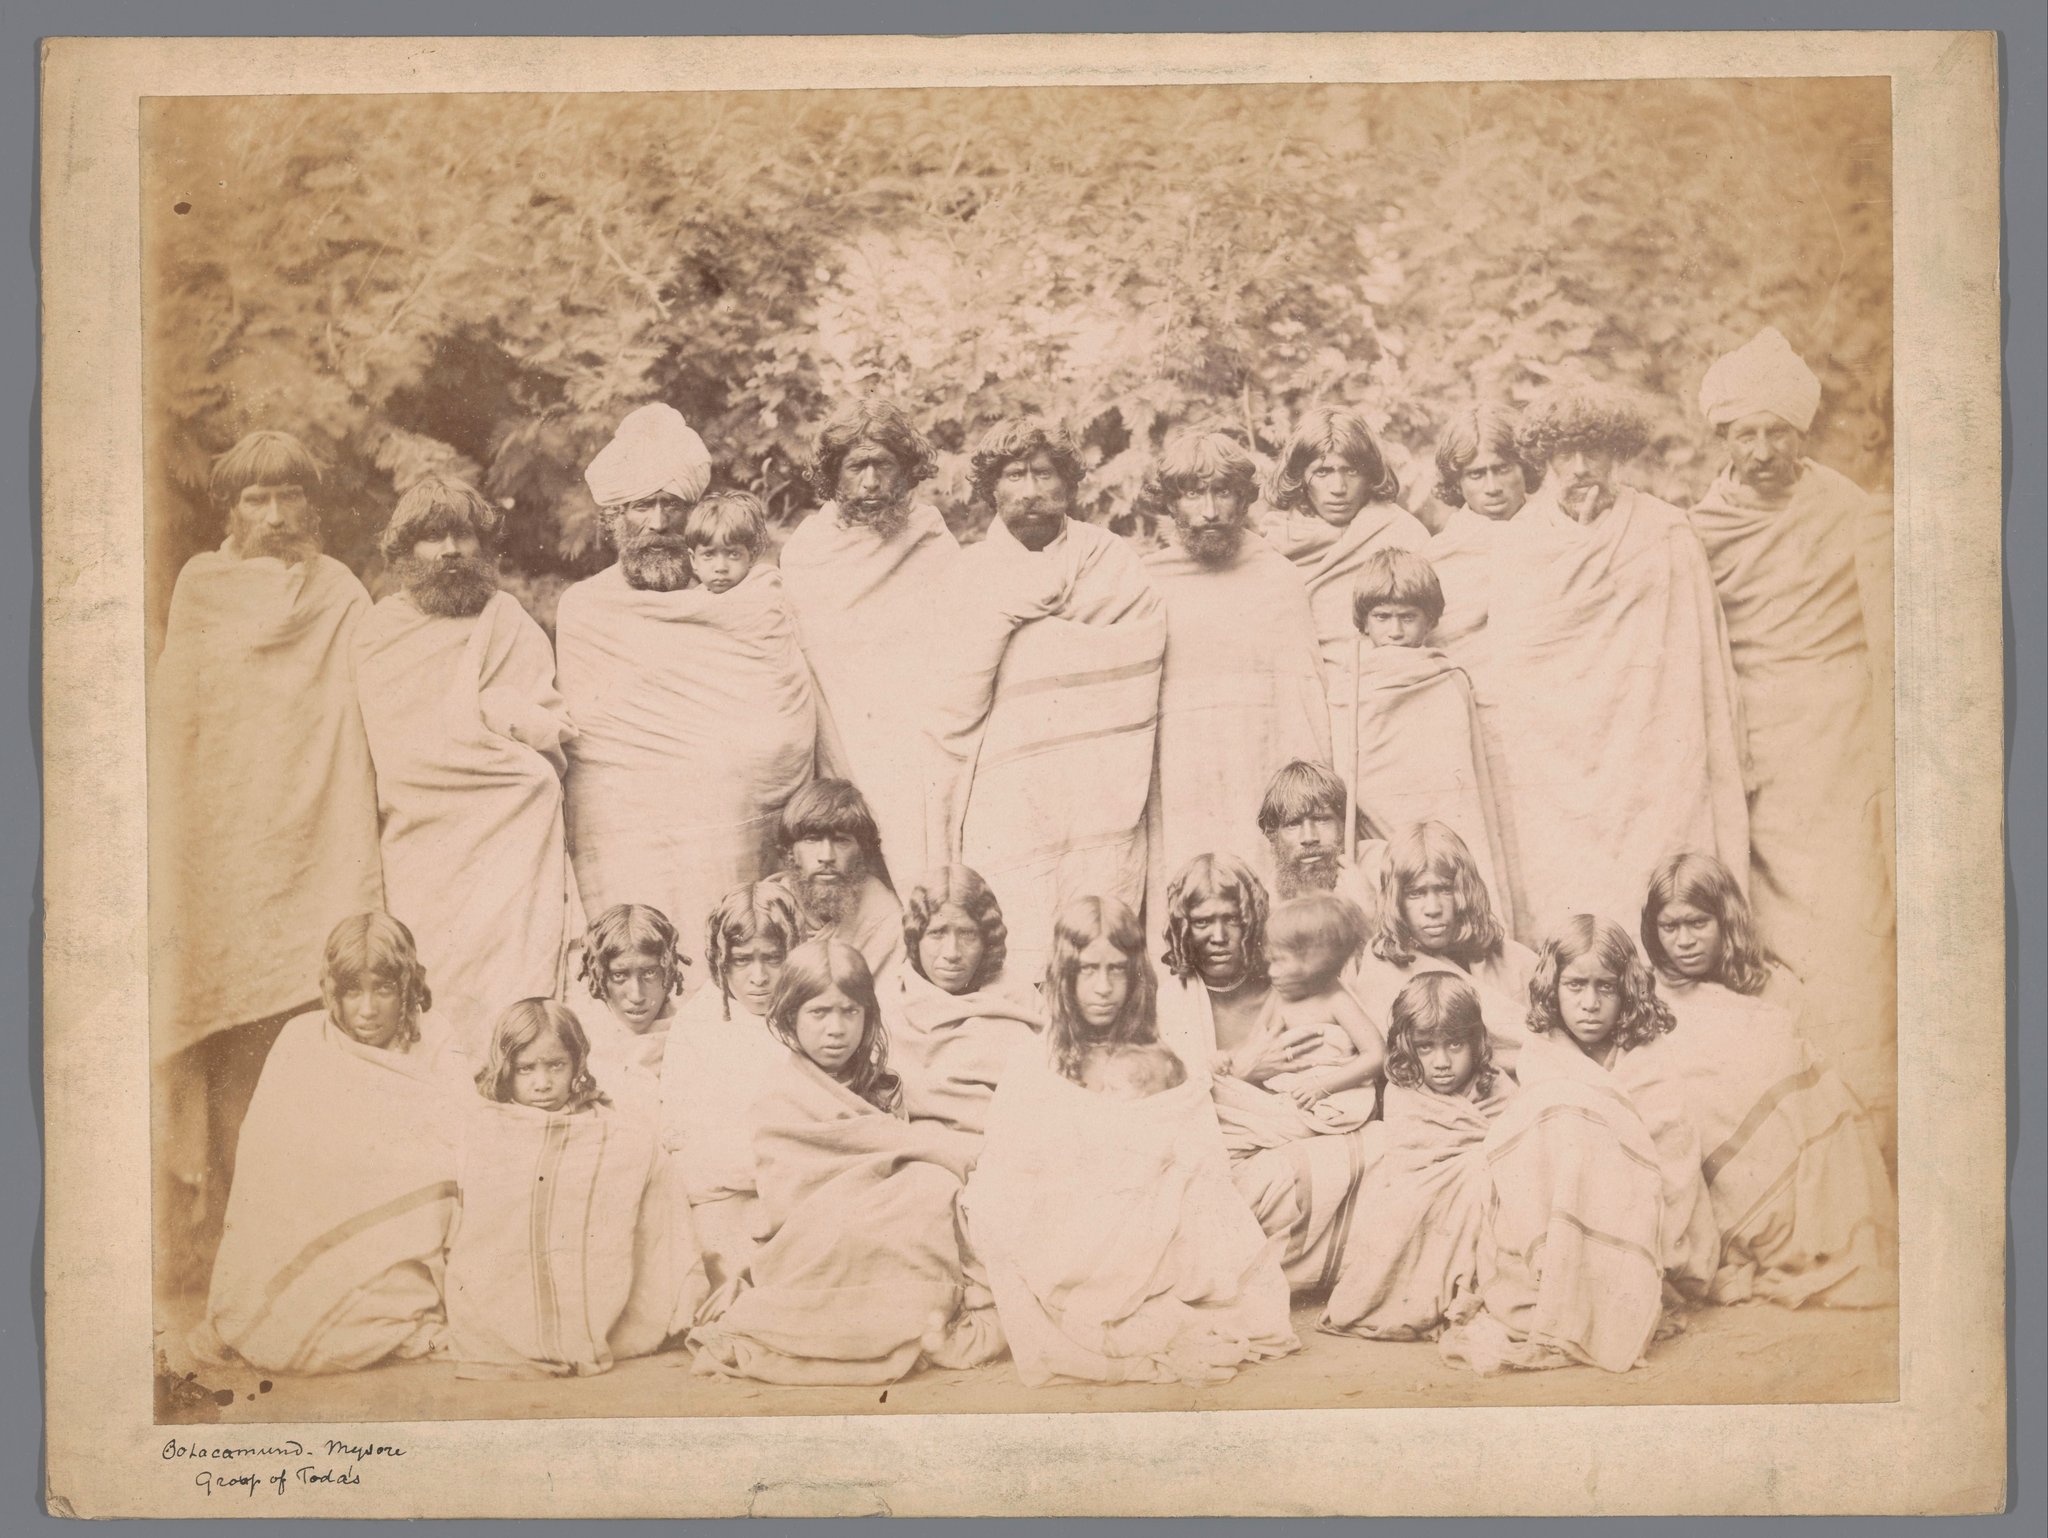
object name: photograph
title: Group portrait of the Toda community in the Nilgiri hills near Ooty, Tamil Nadu, India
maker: Anonymous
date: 1865-1890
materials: cardboard, paper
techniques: albumen print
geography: nilgiri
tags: folk costume, regional costume, anonymous historical persons portrayed in a group, in a group-portrait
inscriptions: title: ‘Ootacamund - Mysore/ Group of Toda's’, inscription: ‘1 [?]’